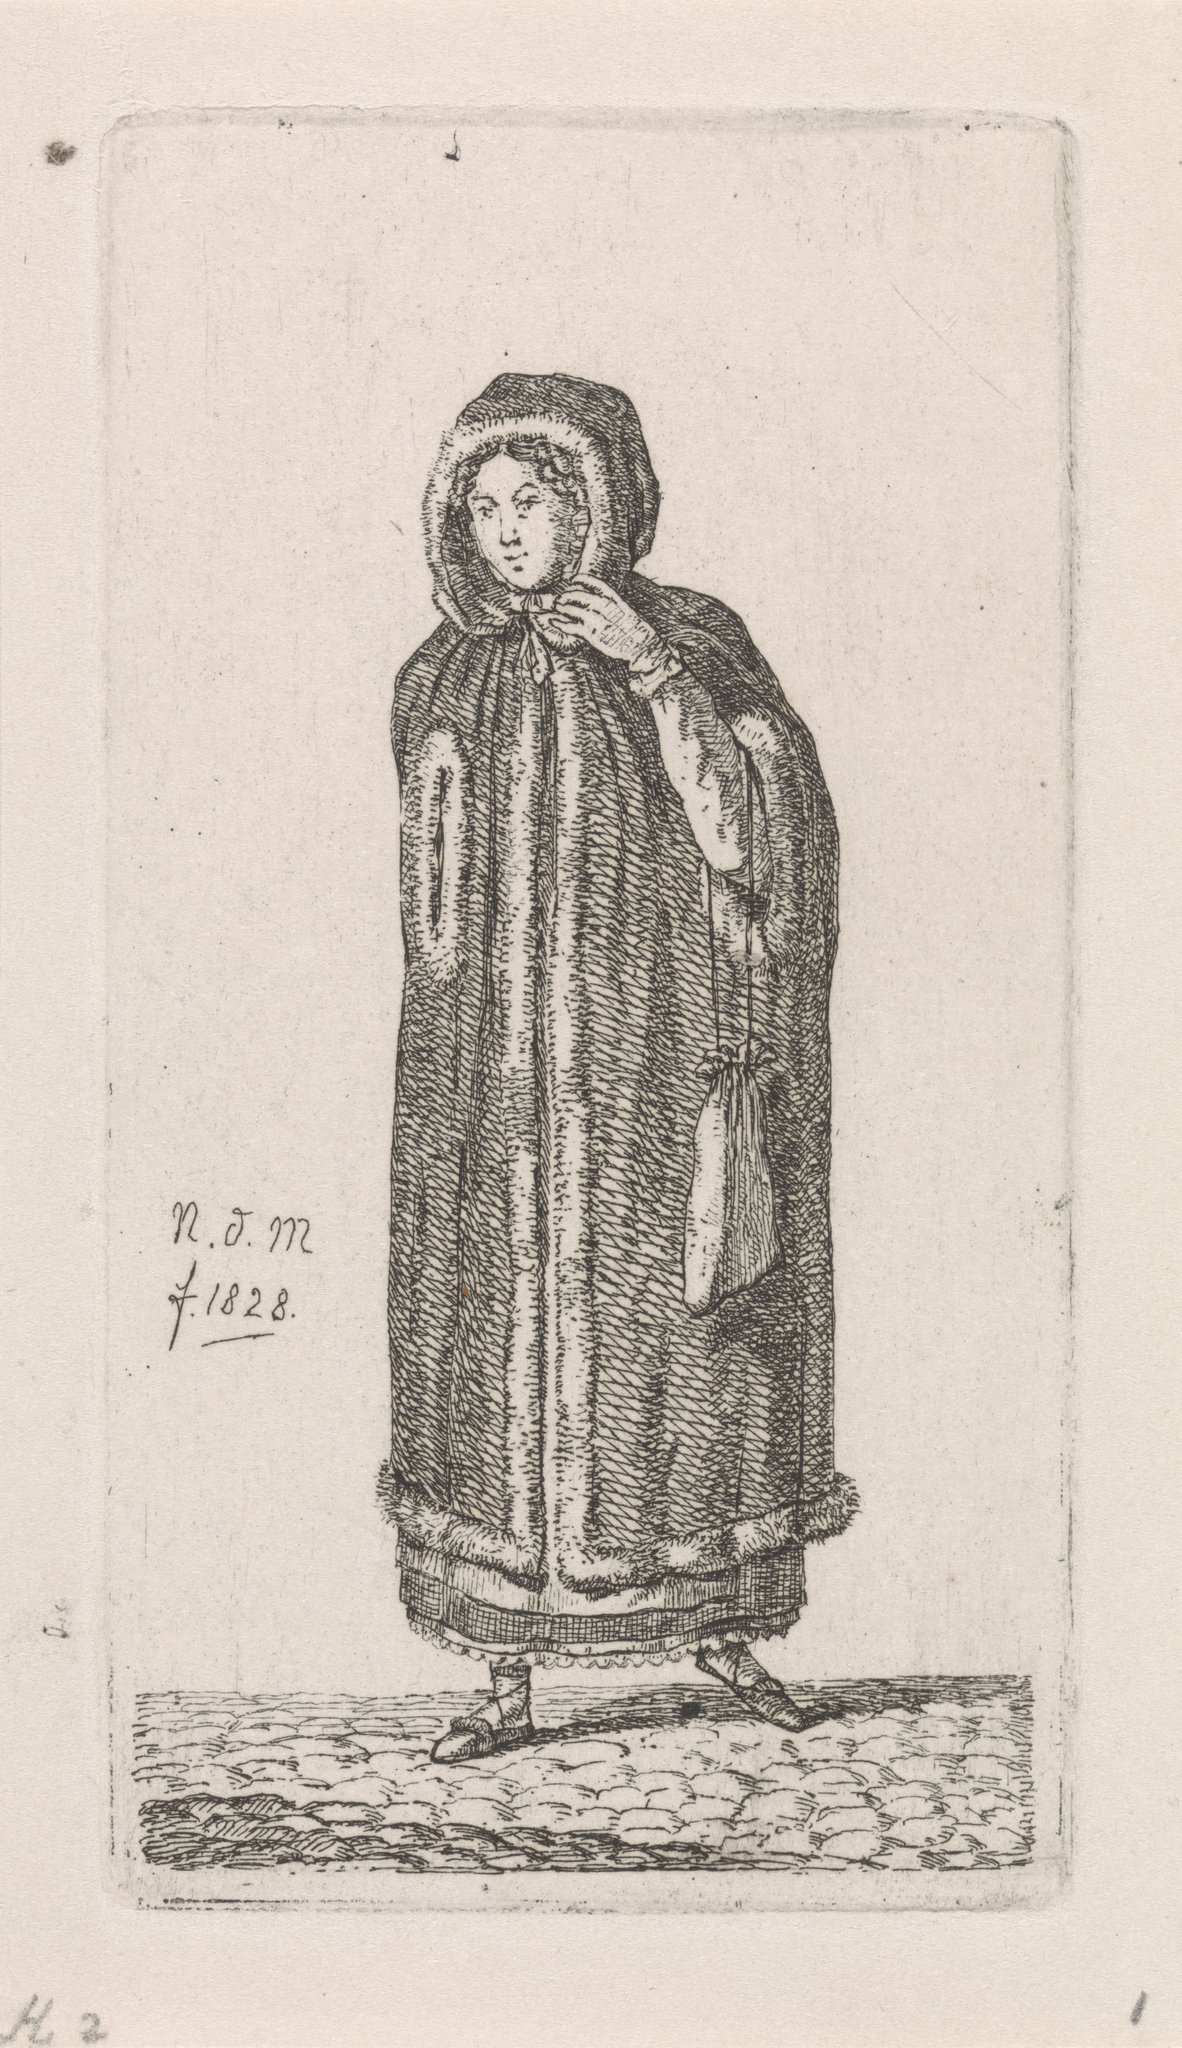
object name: print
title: Vrouw met mantel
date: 1828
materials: paper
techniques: etching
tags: cape (+ women's clothes)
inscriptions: collector's mark: Lugt 2228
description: Vrouw met lange cape met capuchon, gevoerd met bont, haar rechteram naar binnen gestoken. Prent uit een serie van twaalf prenten met studies van menselijke figuren.